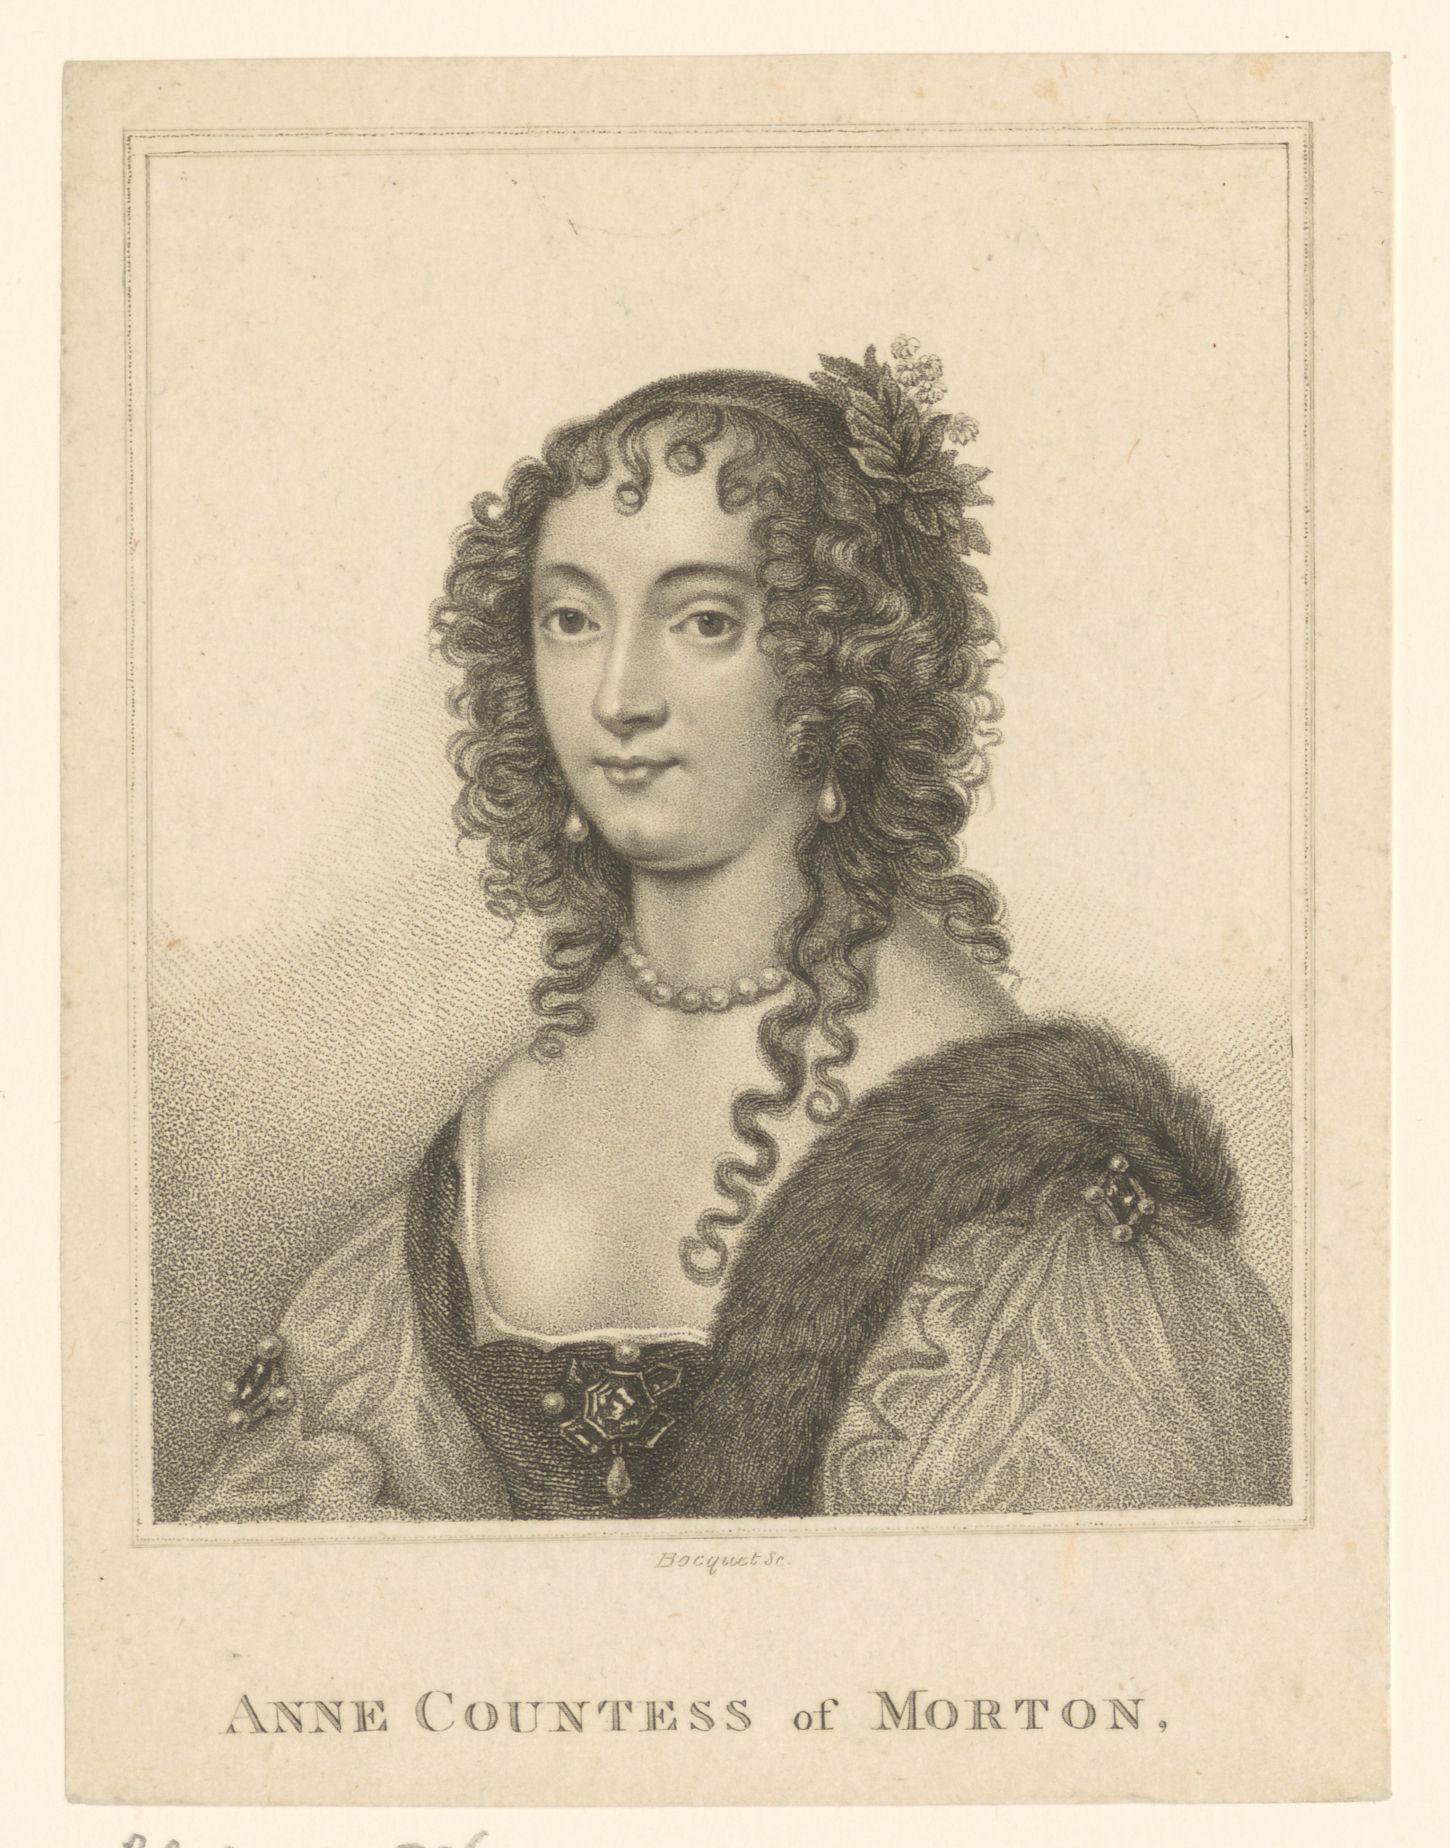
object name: print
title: Portret van Anna Dalkeith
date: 1807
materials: paper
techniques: etching, engraving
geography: london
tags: historical persons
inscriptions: collector's mark: Lugt 2228